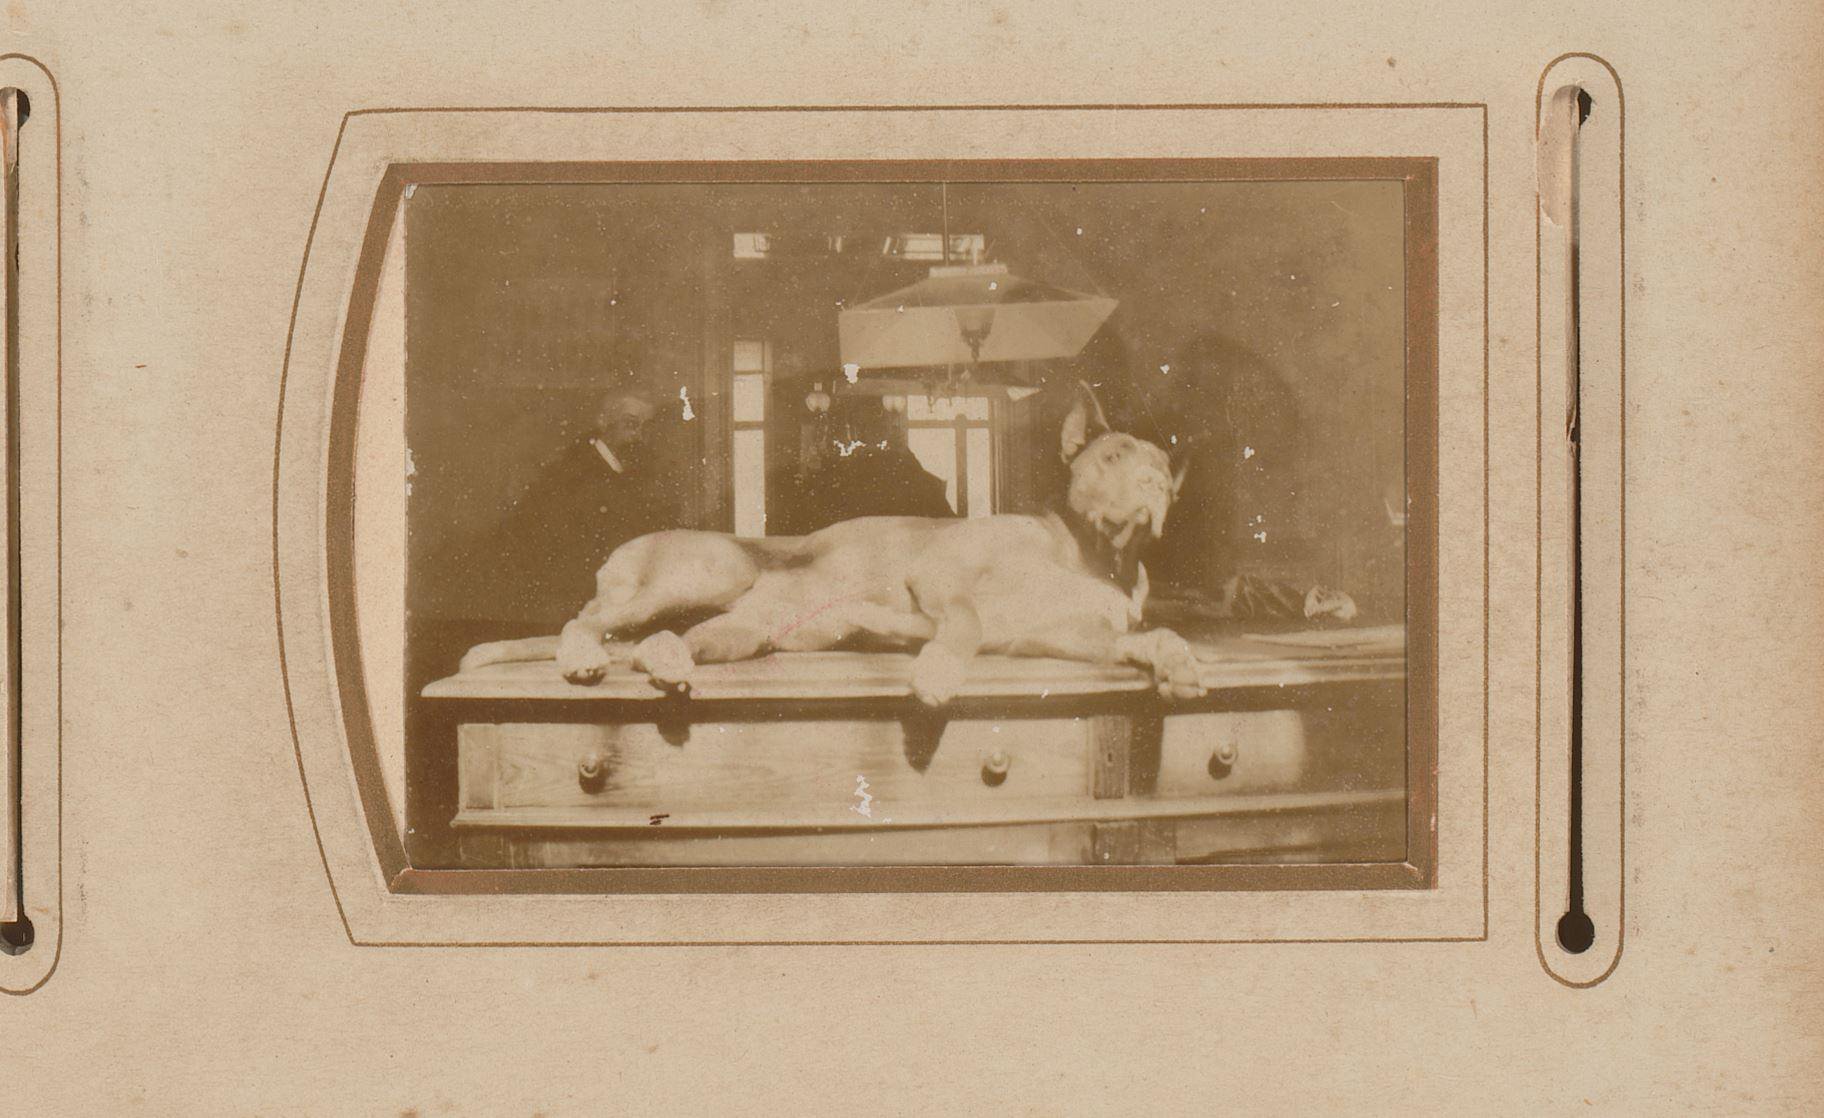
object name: album leaf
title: Hond, liggend op een tafel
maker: Anonymous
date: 1882-1920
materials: cardboard, photographic support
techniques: gelatin silver print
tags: table, dog